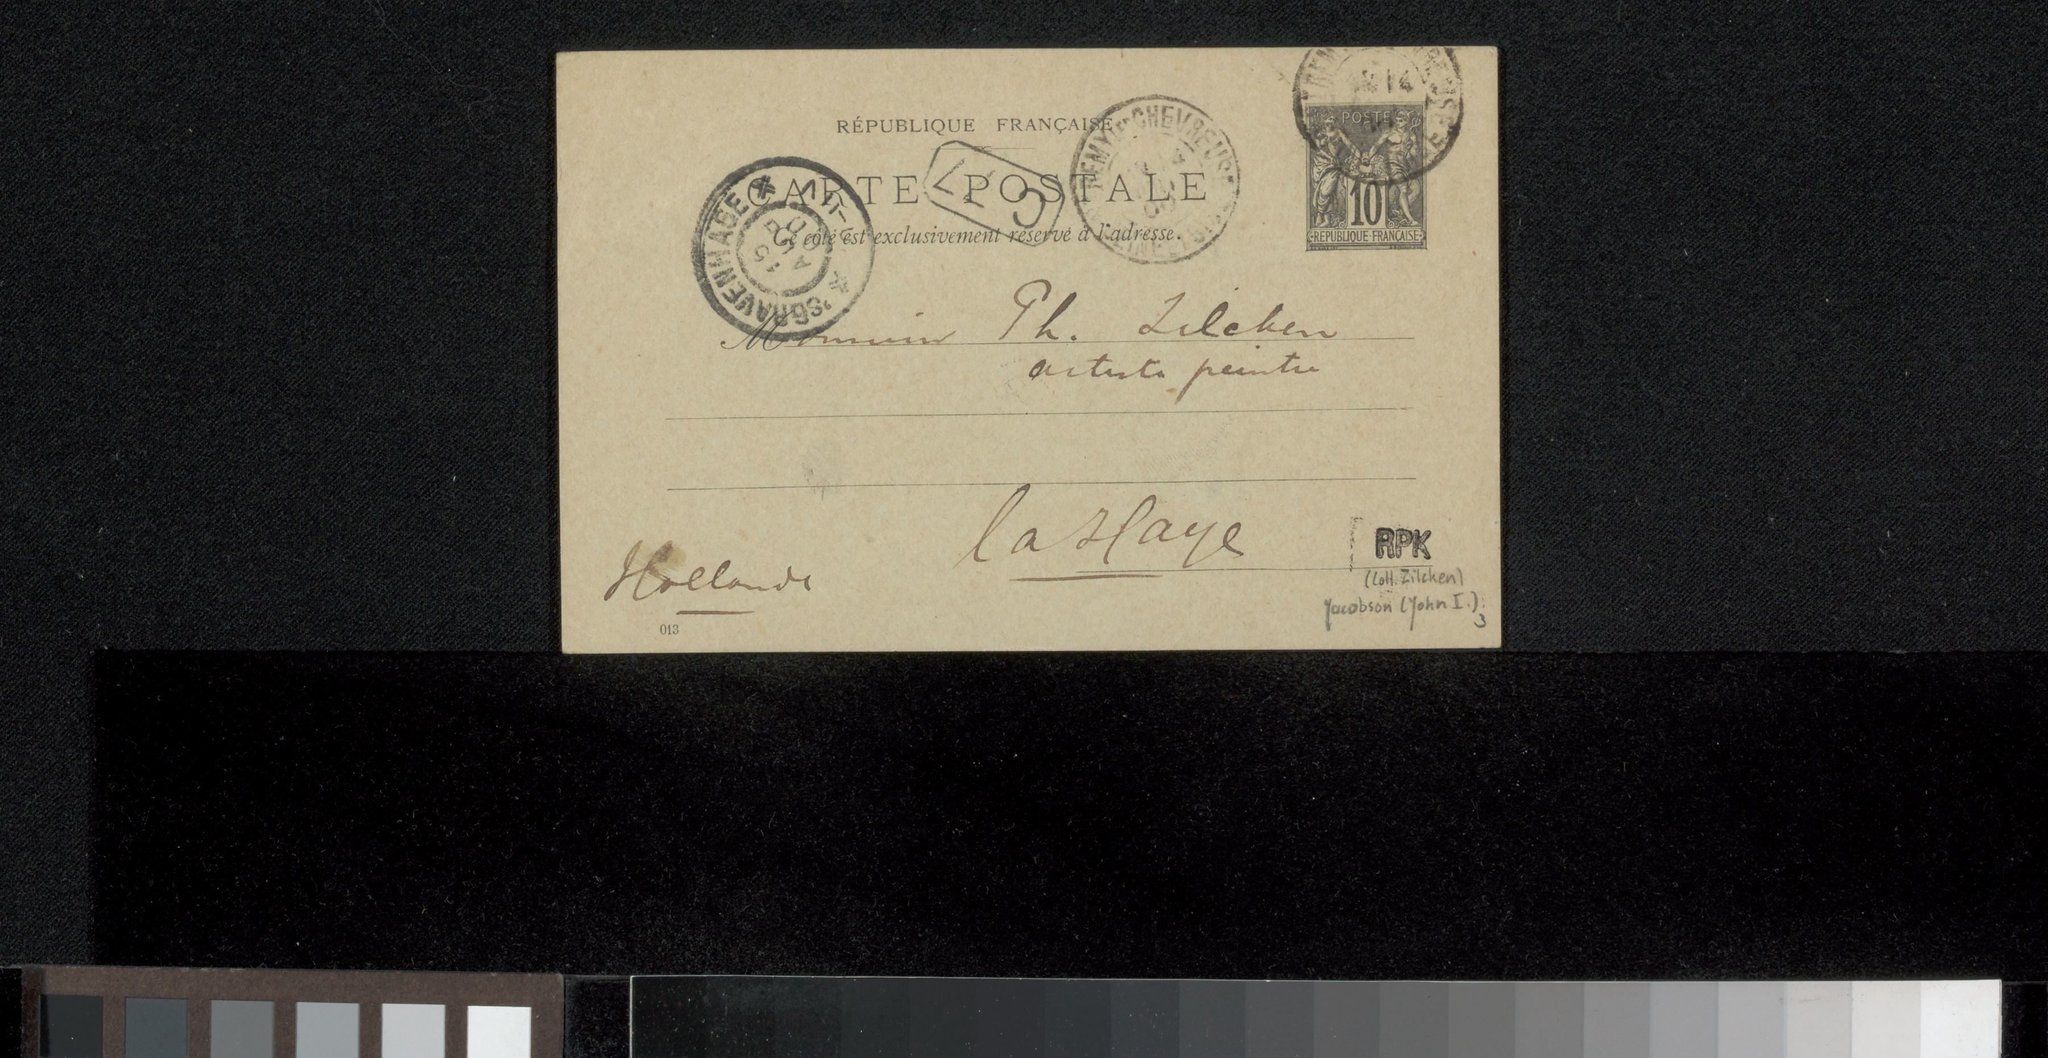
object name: postcard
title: Briefkaart aan Philip Zilcken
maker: john jacobson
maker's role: draughtsman, painter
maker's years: 1867-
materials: cardboard, ink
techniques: pen, writing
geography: saint-rémy-lès-chevreuse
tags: louis couperus, rotterdam, amsterdam, herman robbers, the hague, painter, draughtsman, philip zilcken, drawing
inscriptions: collector's mark: ‘RPK’